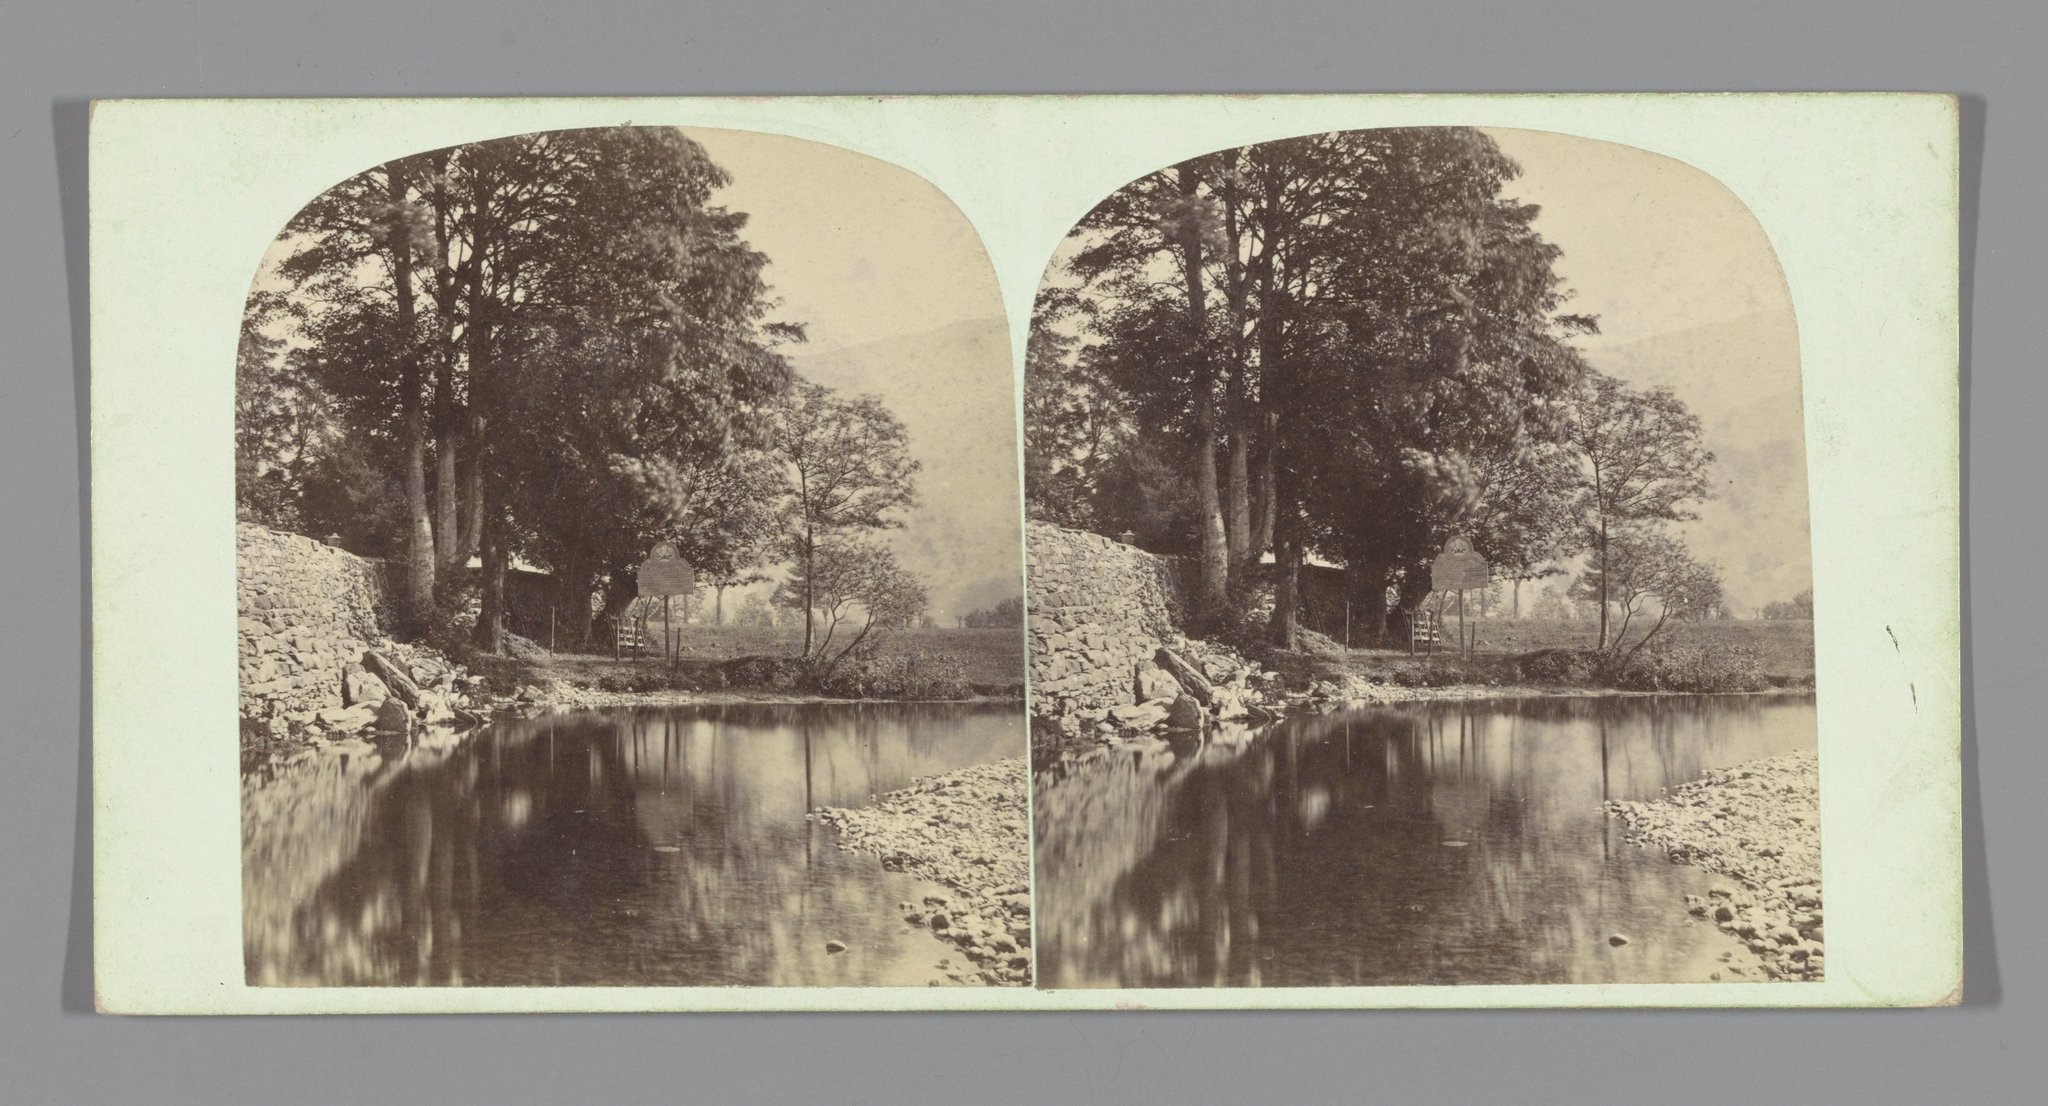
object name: stereograph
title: Gezicht op bomen langs Grasmere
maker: helmut petschler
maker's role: fotograaf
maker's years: 1832-1869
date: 1850-1880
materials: cardboard, photographic support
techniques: albumen print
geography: grasmere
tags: trees, lake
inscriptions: number: ‘No. 192.’, inscription: ‘Photographed by H. Petschler, Printed & Published by The Manchester Photographic Company, Limited, Late H. Petschler & Co, 82 & 84, Market-st., Manchester.’, inscription: ‘English Lakes.’